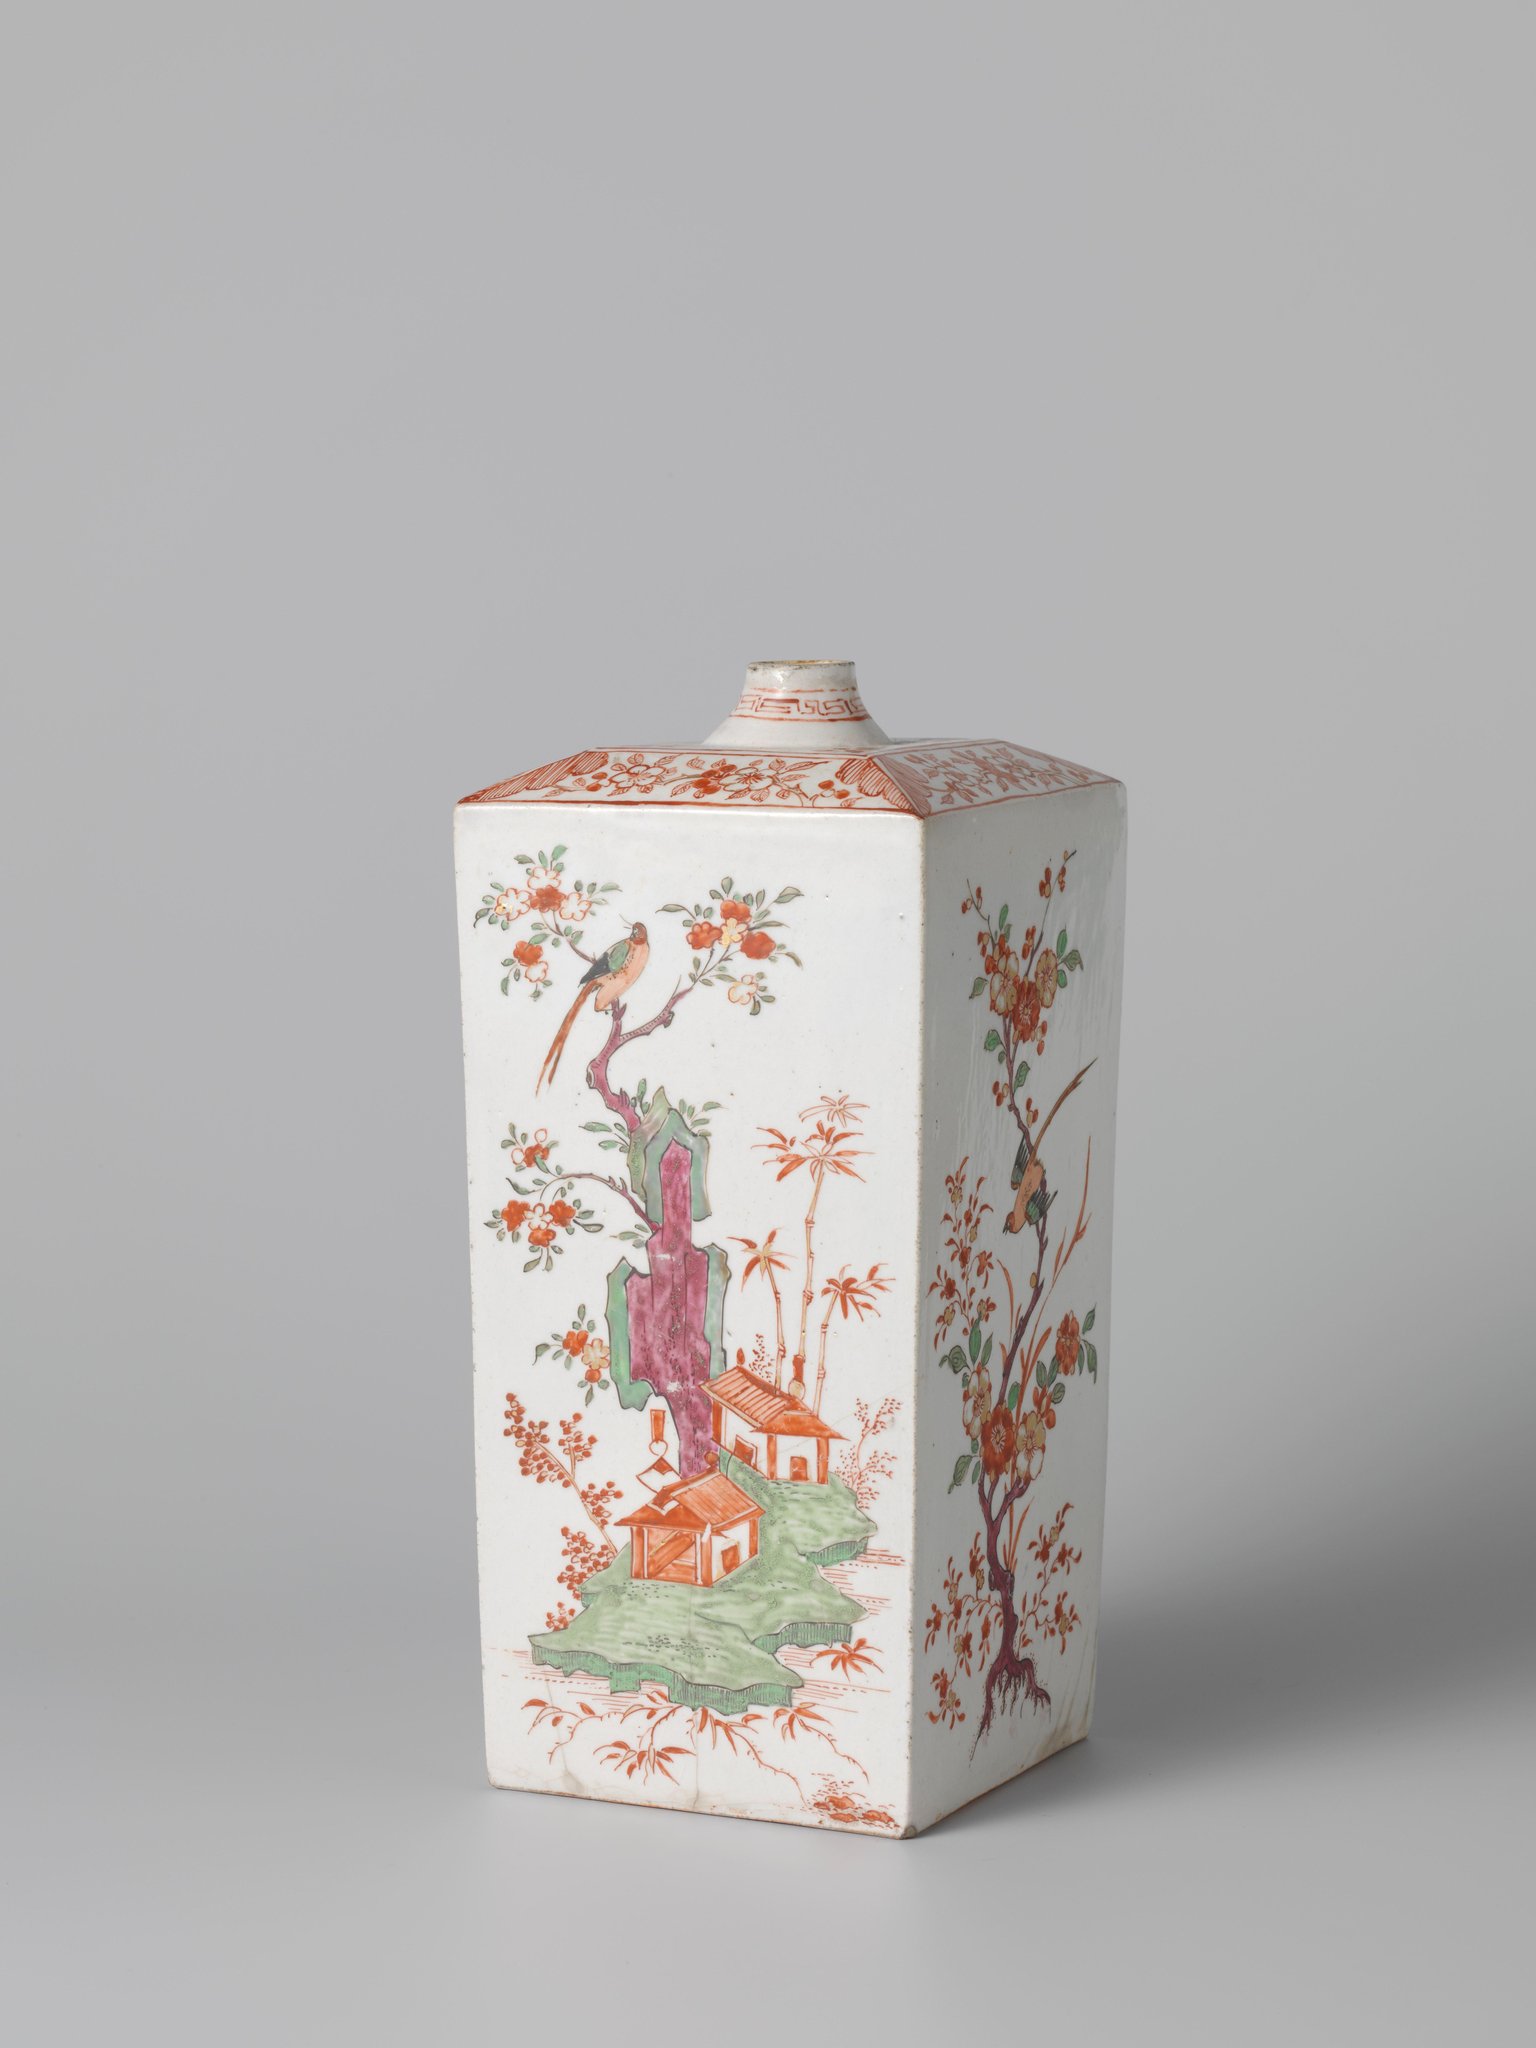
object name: bottle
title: Square bottle with birds, flowering plants and pavilions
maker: Anonymous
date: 1700-1724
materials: glaze, gold, paint, porcelain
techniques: firing, forming, gilding, vitrification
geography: arita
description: Vierkante fles van porselein, beschilderd op het glazuur in rood, groen, geel, paars, zwart en goud. Op de wanden tweemaal paviljoens op een eiland met rotsen en bloeiende planten (bamboe), een vogel op een tak, en tweemaal een vliegende vogel bij een prunustak en bamboe. Op de schouder een band met prunustakken en een bladmotief; rond de hals ranken. Op de hals een meanderpatroon. De rand is afgeslepen. Een chip in de voet en enkele barsten. Arita, in Europa gedecoreerd [?] in de Japanse Kakiemon-stijl.